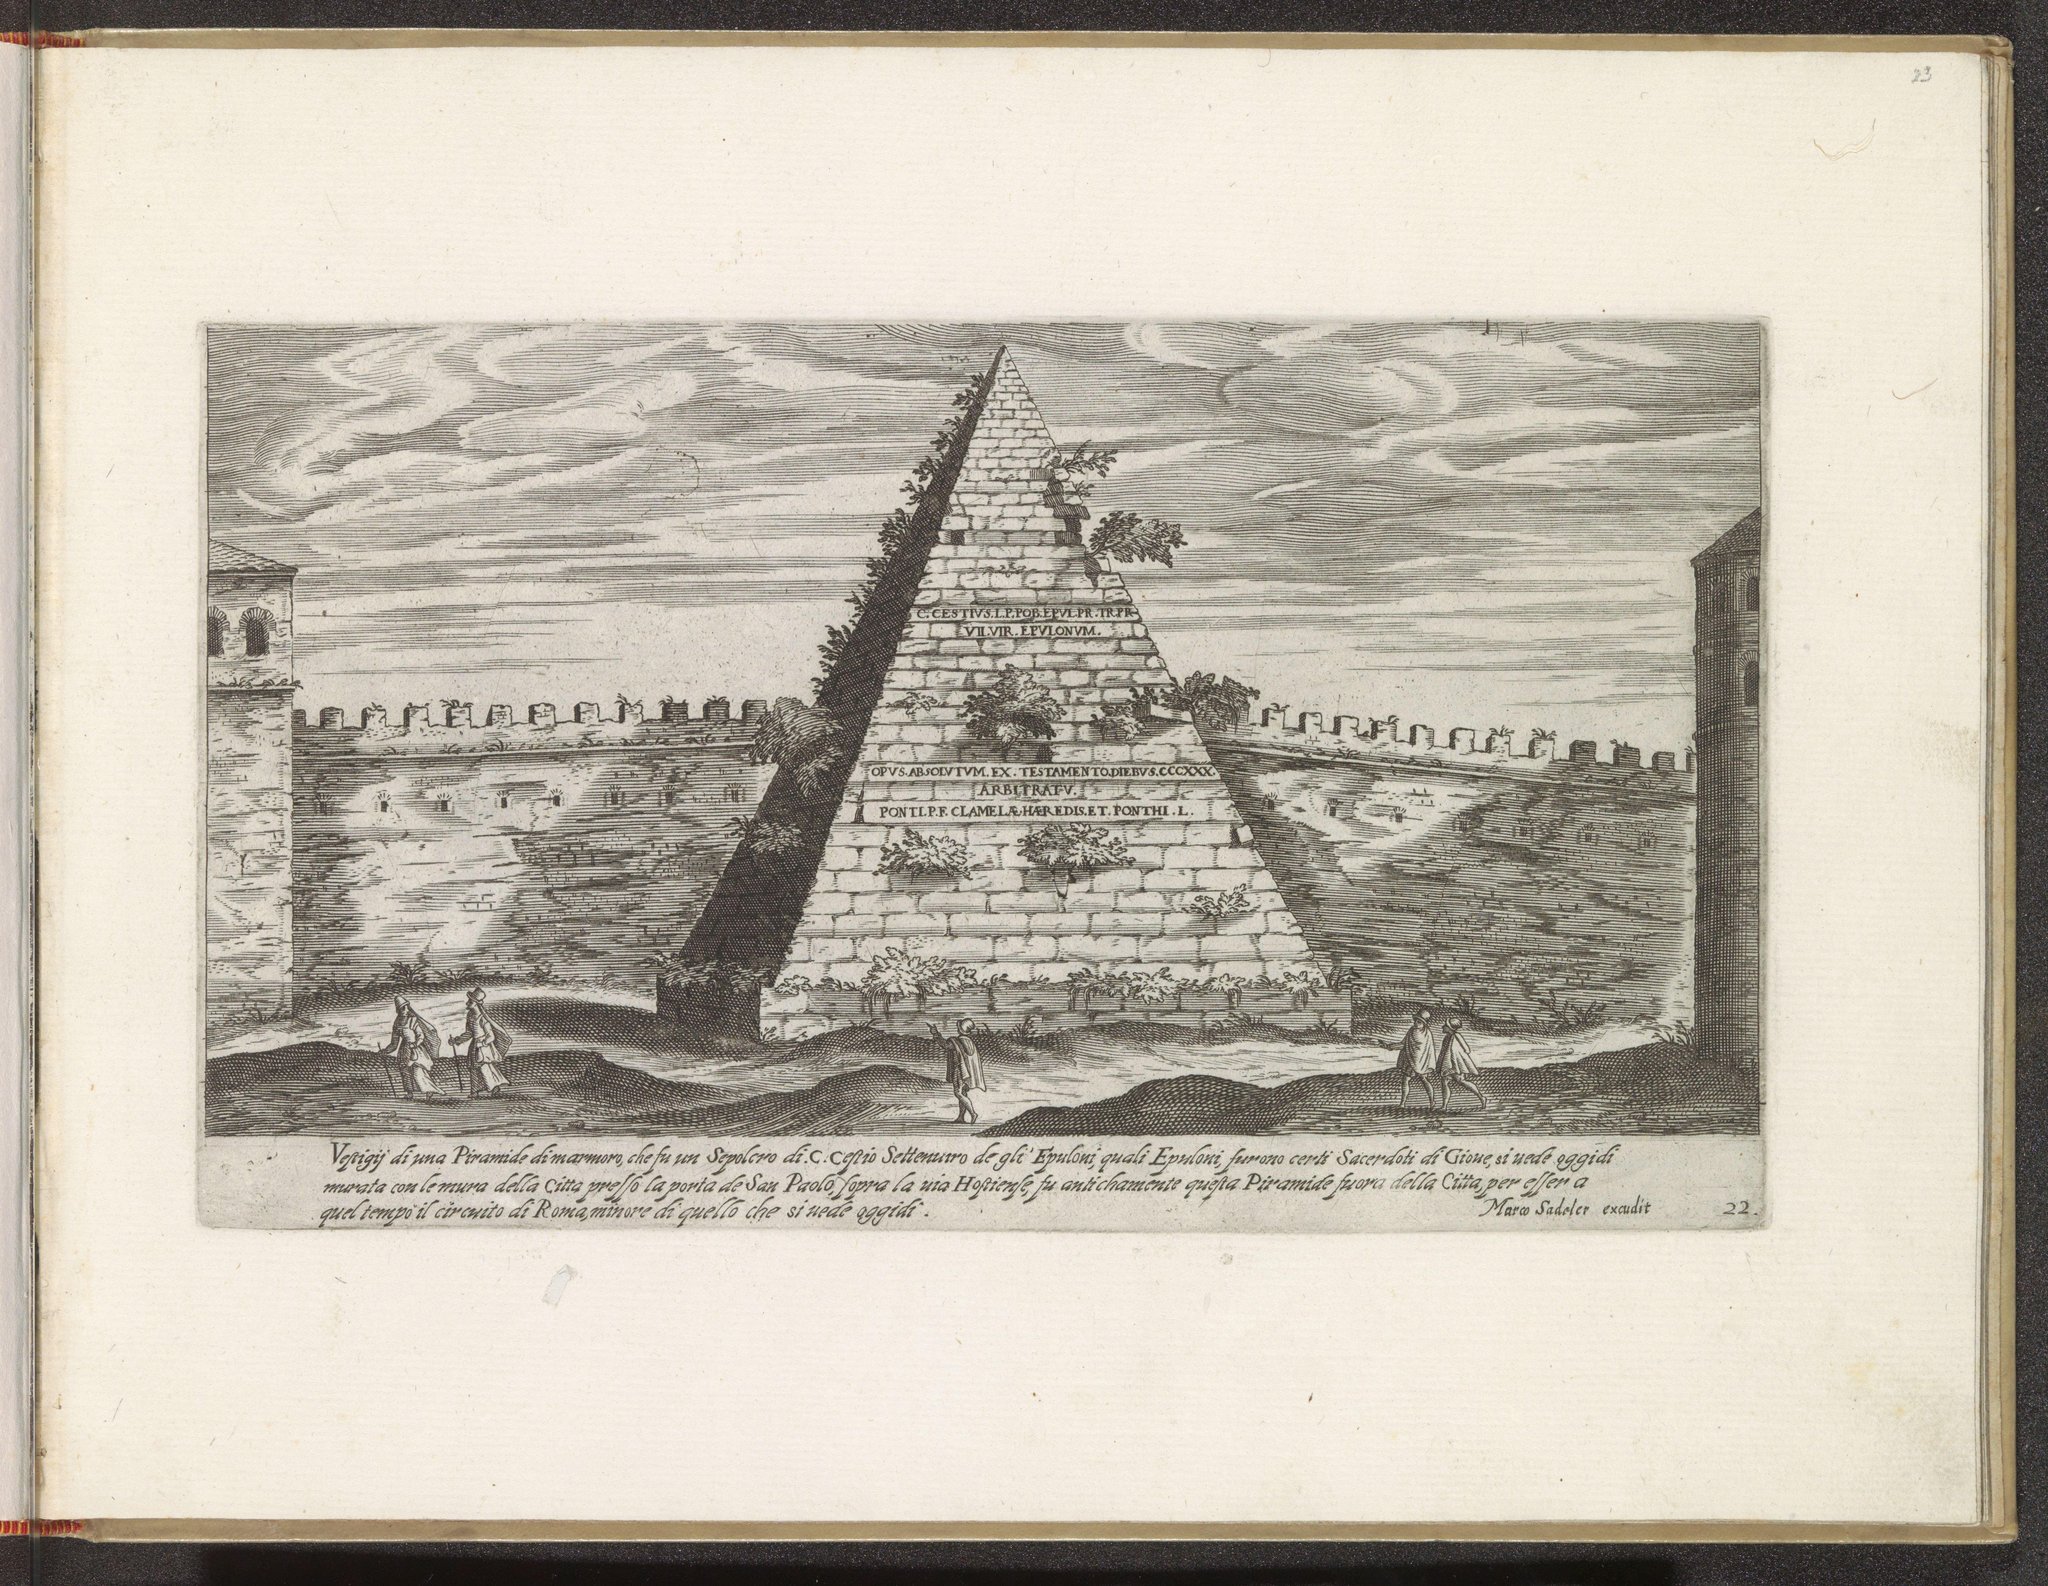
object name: album leaf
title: Piramide van Cestius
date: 1606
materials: paper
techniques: engraving, etching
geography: prague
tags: rome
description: De Piramide van Cestius, gebouwd als grafmonument voor Gaius Cestius Epulonius. De piramide is opgenomen in de Aureliaanse muur. In de ondermarge drie regels tekst in het Italiaans. De prent maakt deel uit van een album.